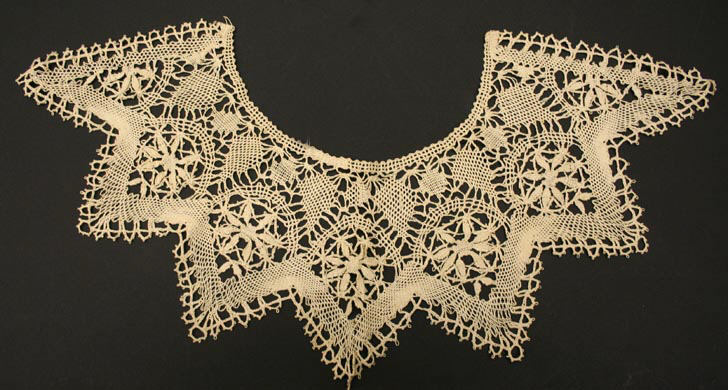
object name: collar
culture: american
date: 1700-1943